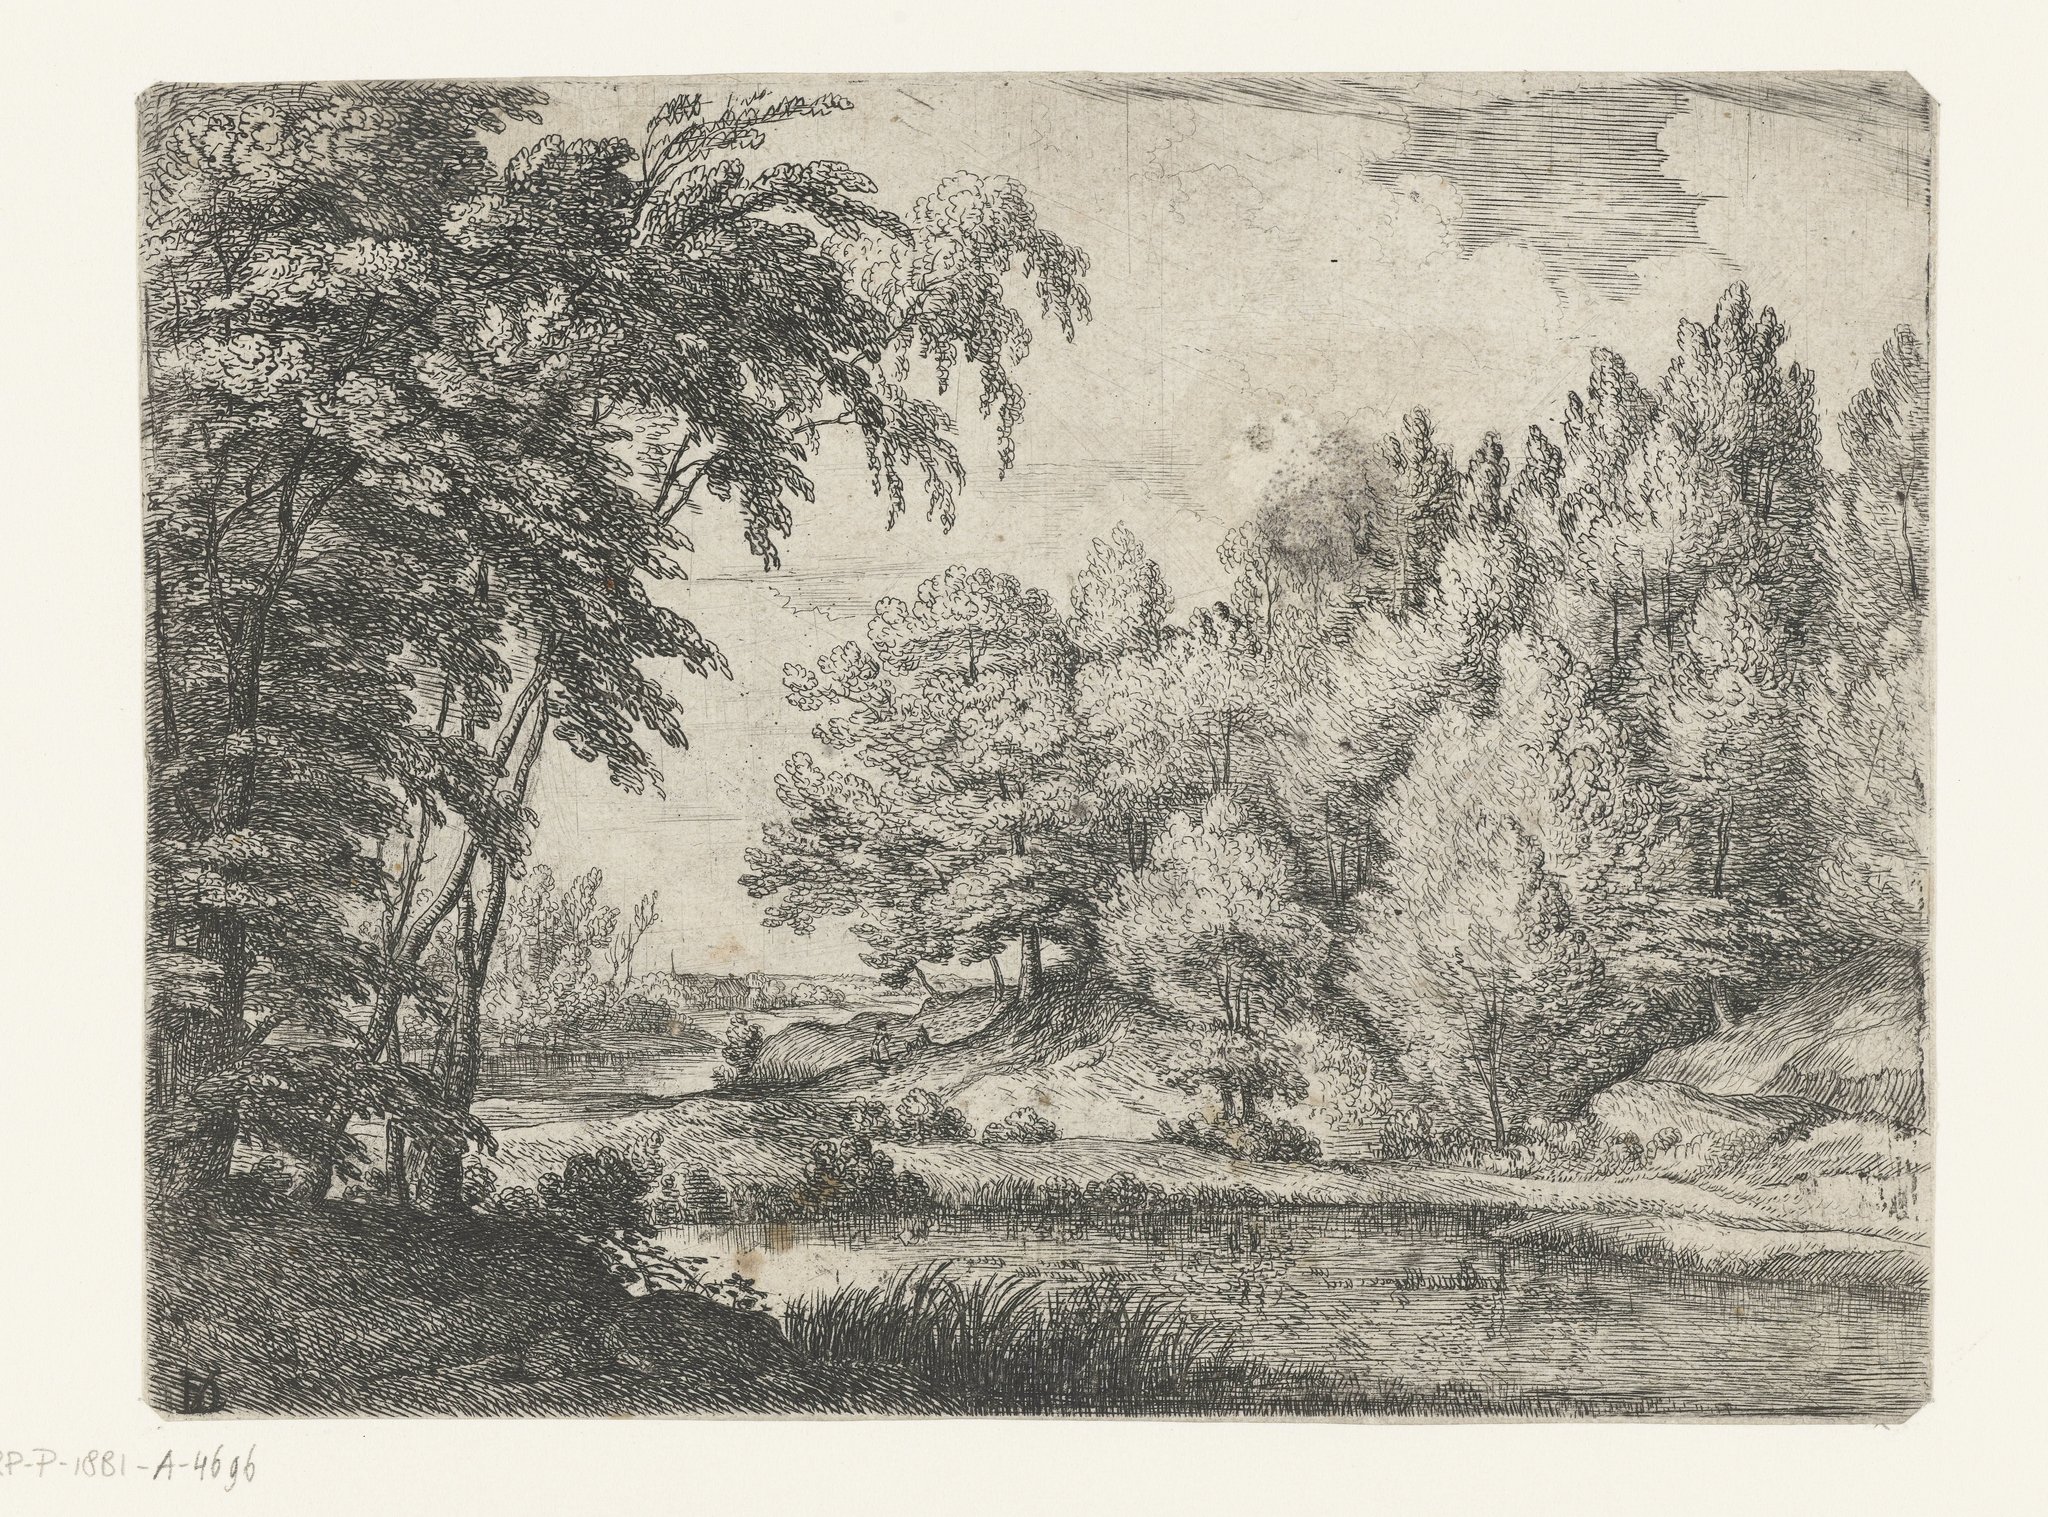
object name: print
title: Landschap met een kronkelende rivier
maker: lodewijk de vadder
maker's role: print maker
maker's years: 1605-1655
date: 1615-1655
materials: paper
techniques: engraving, etching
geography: low countries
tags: river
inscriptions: collector's mark: Lugt 2228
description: Bosachtig landschap met een meanderende rivier, op de oever twee personen, in de verte een dorp.